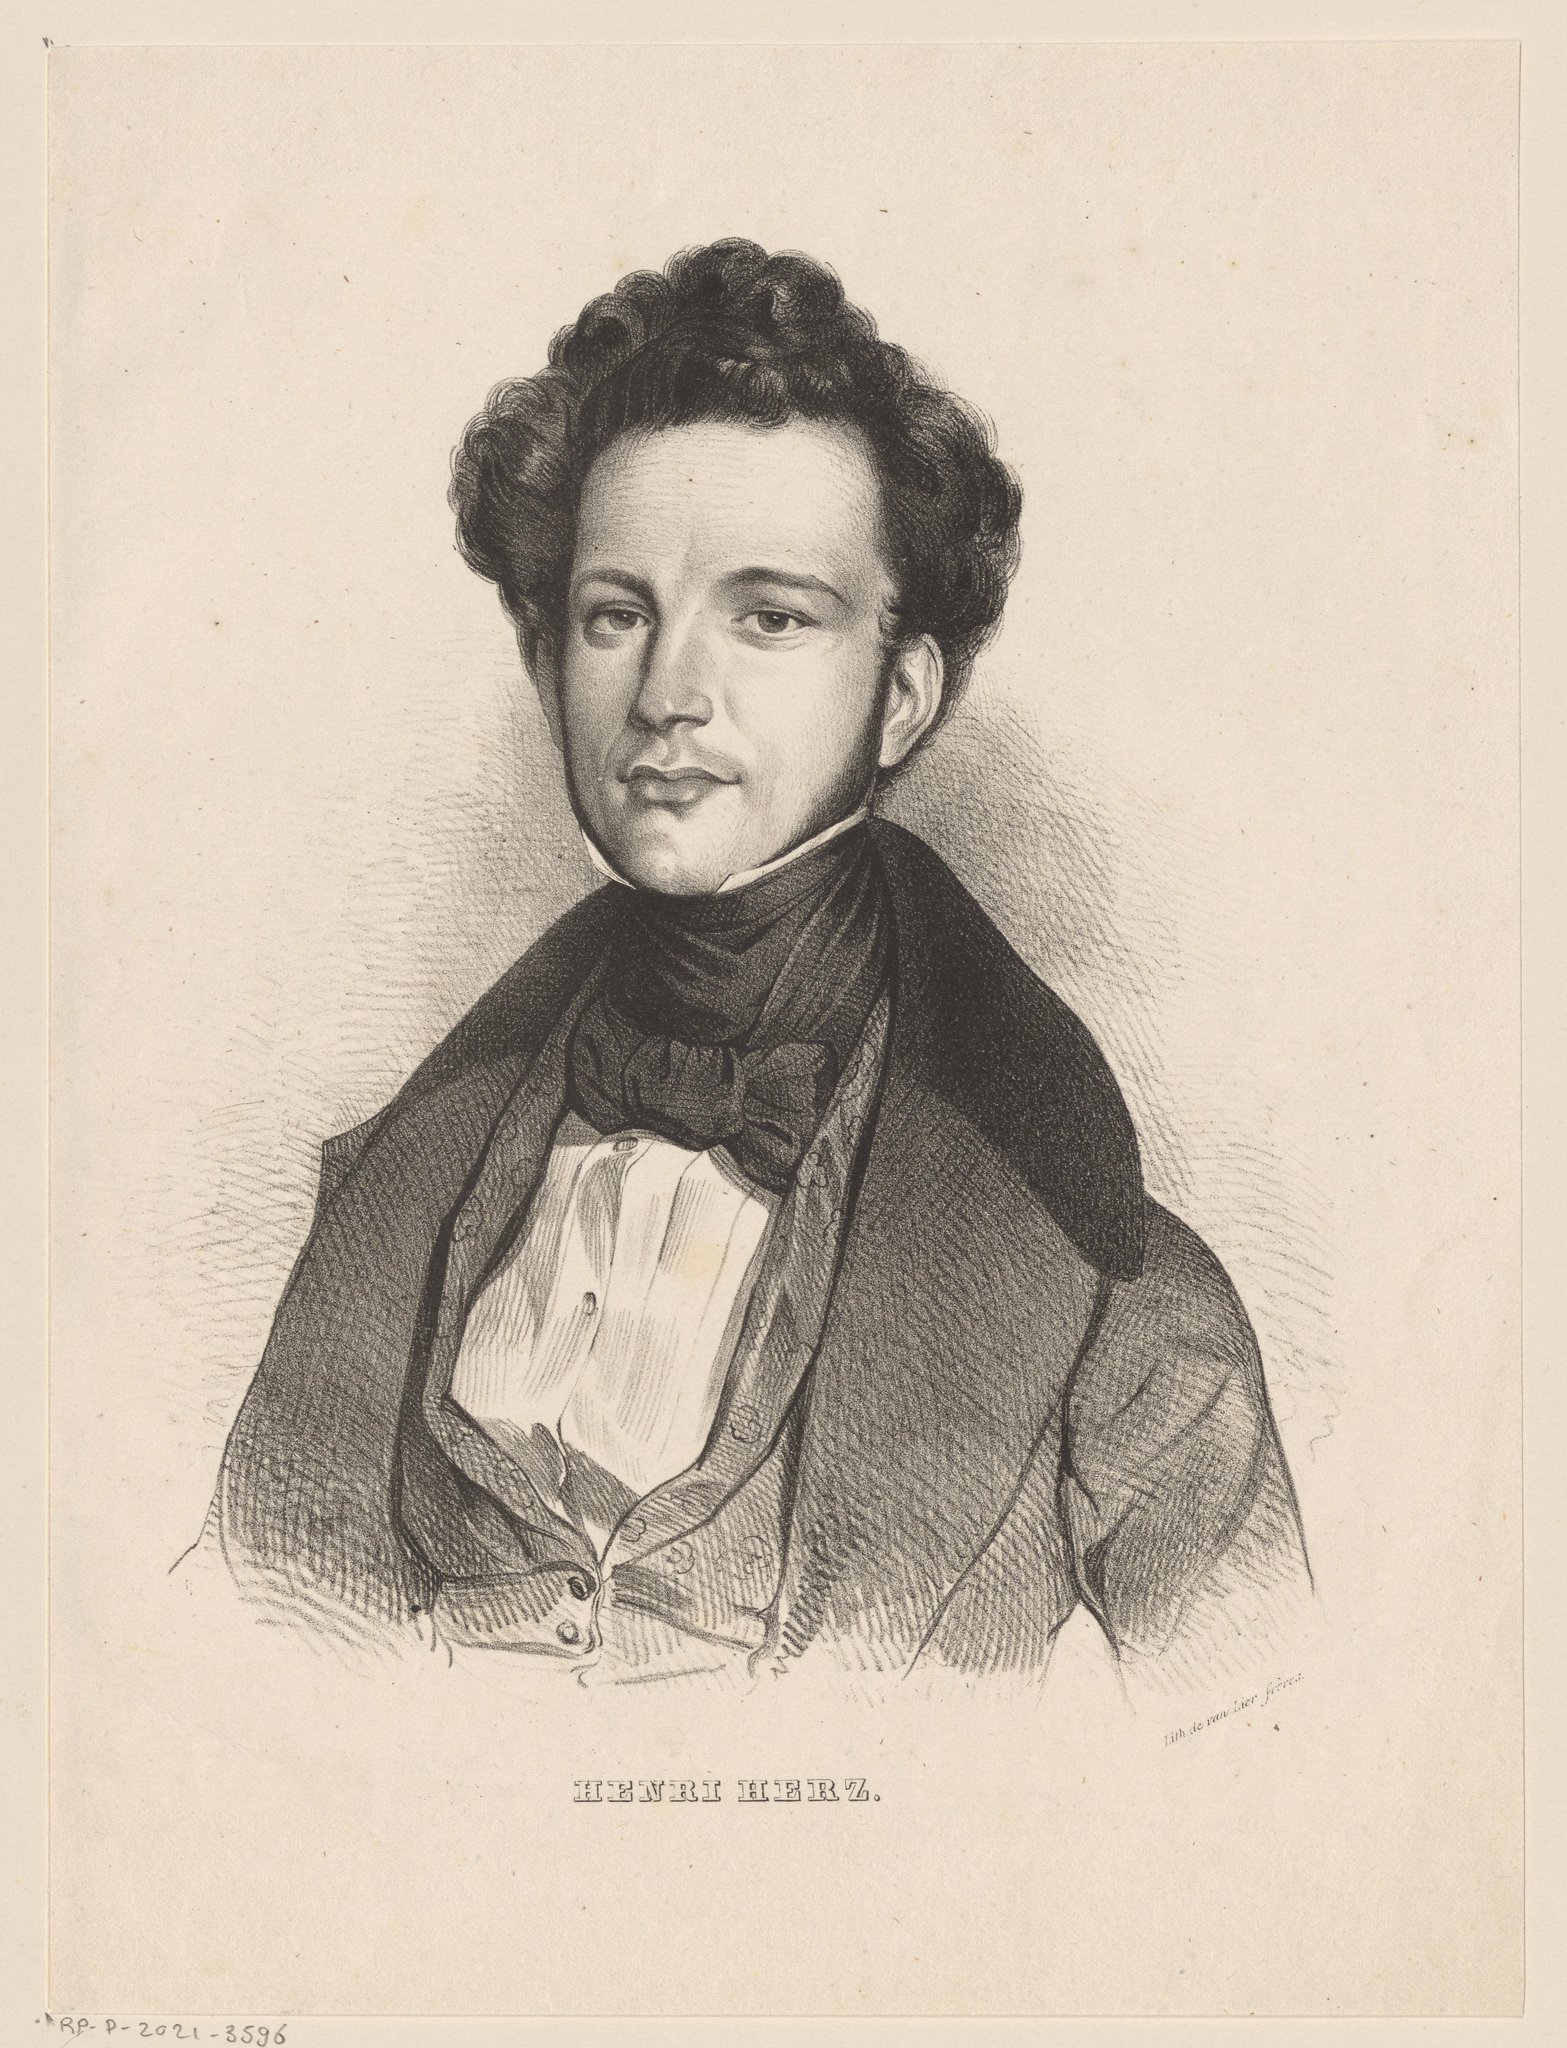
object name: print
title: Portret van Henri Herz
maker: Anonymous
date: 1837-1846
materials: paper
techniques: lithograph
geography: the hague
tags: vienna, paris, henri herz, historical persons, portrait of composer